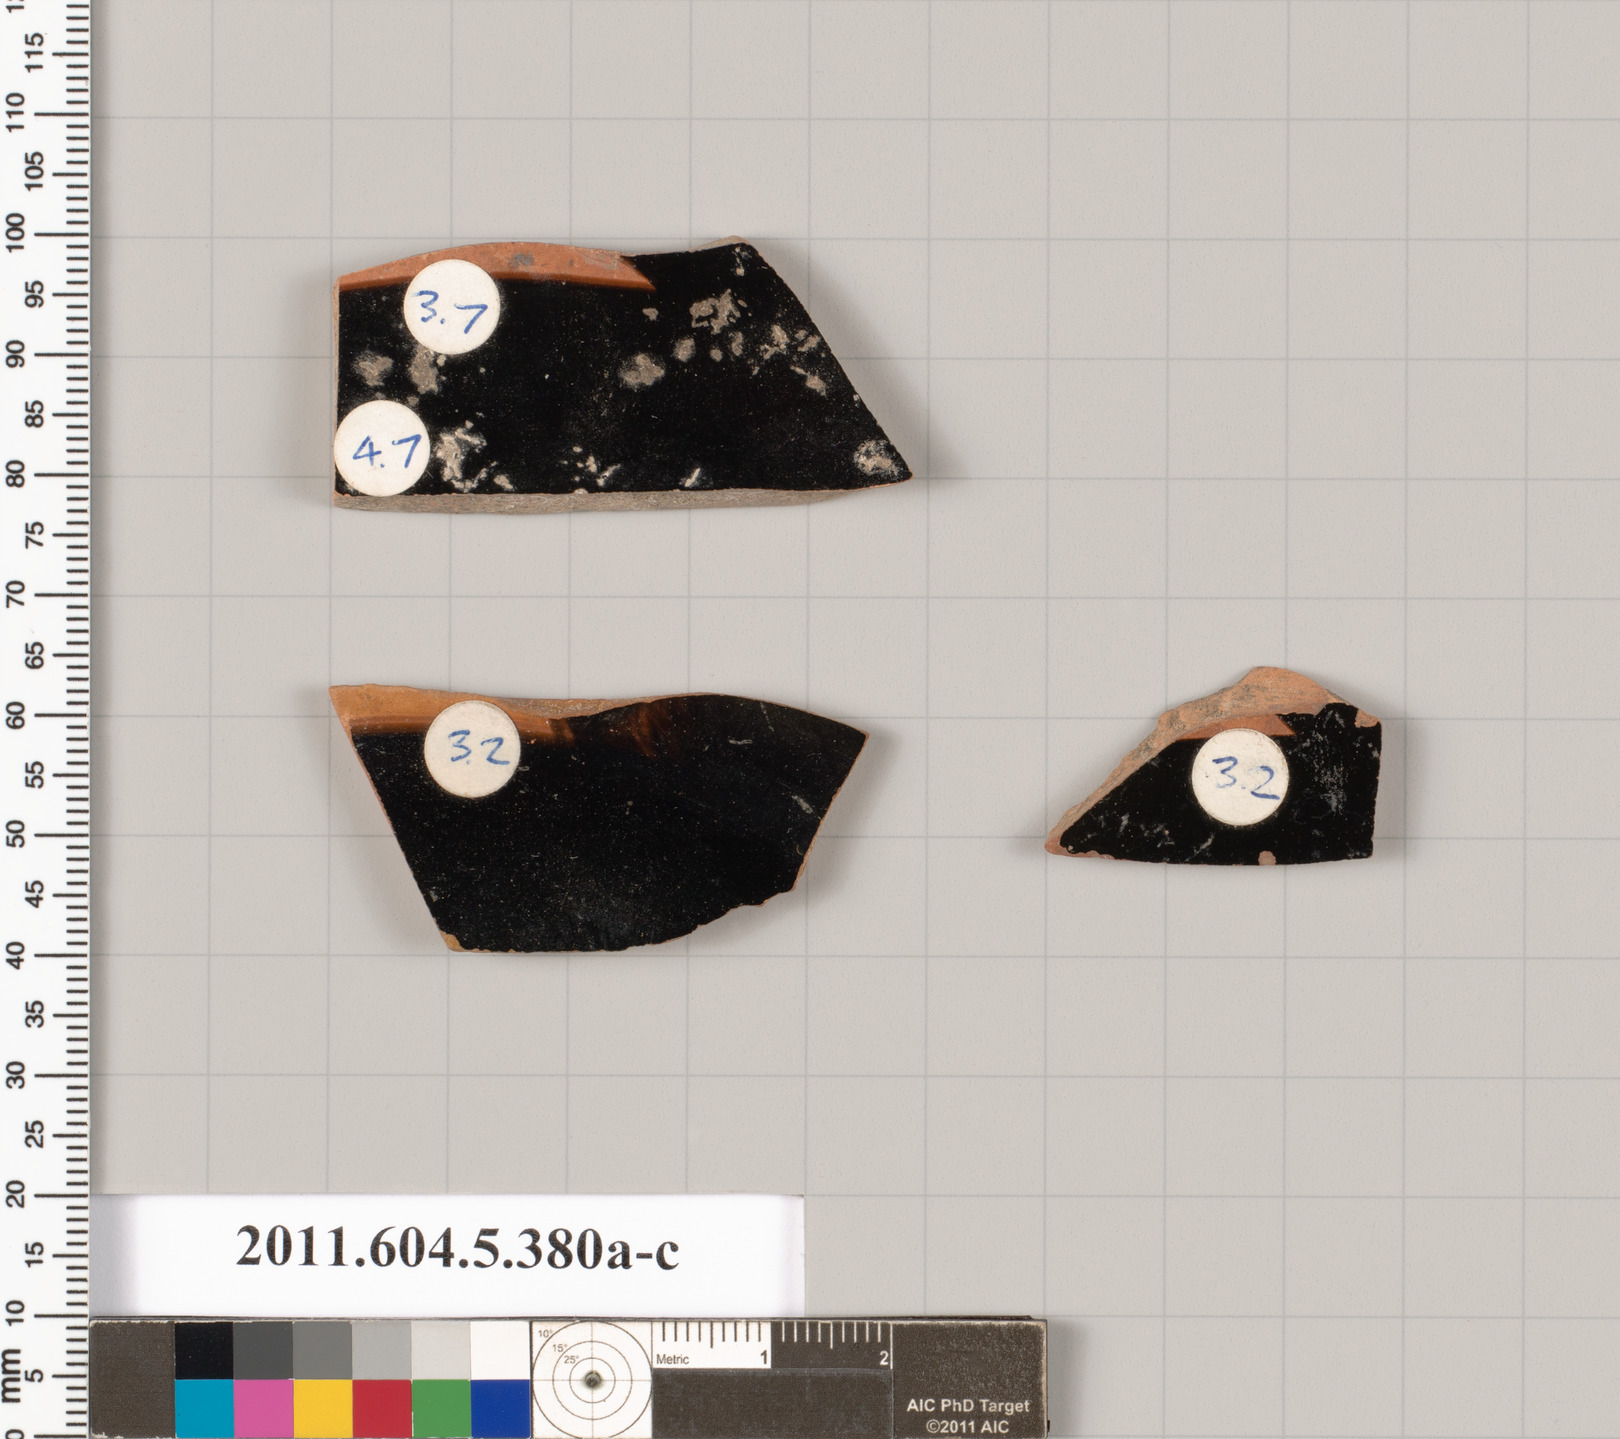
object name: kylix fragment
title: Terracotta fragments of kylikes (drinking cups)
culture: greek, attic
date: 600-401 BCE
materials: terracotta